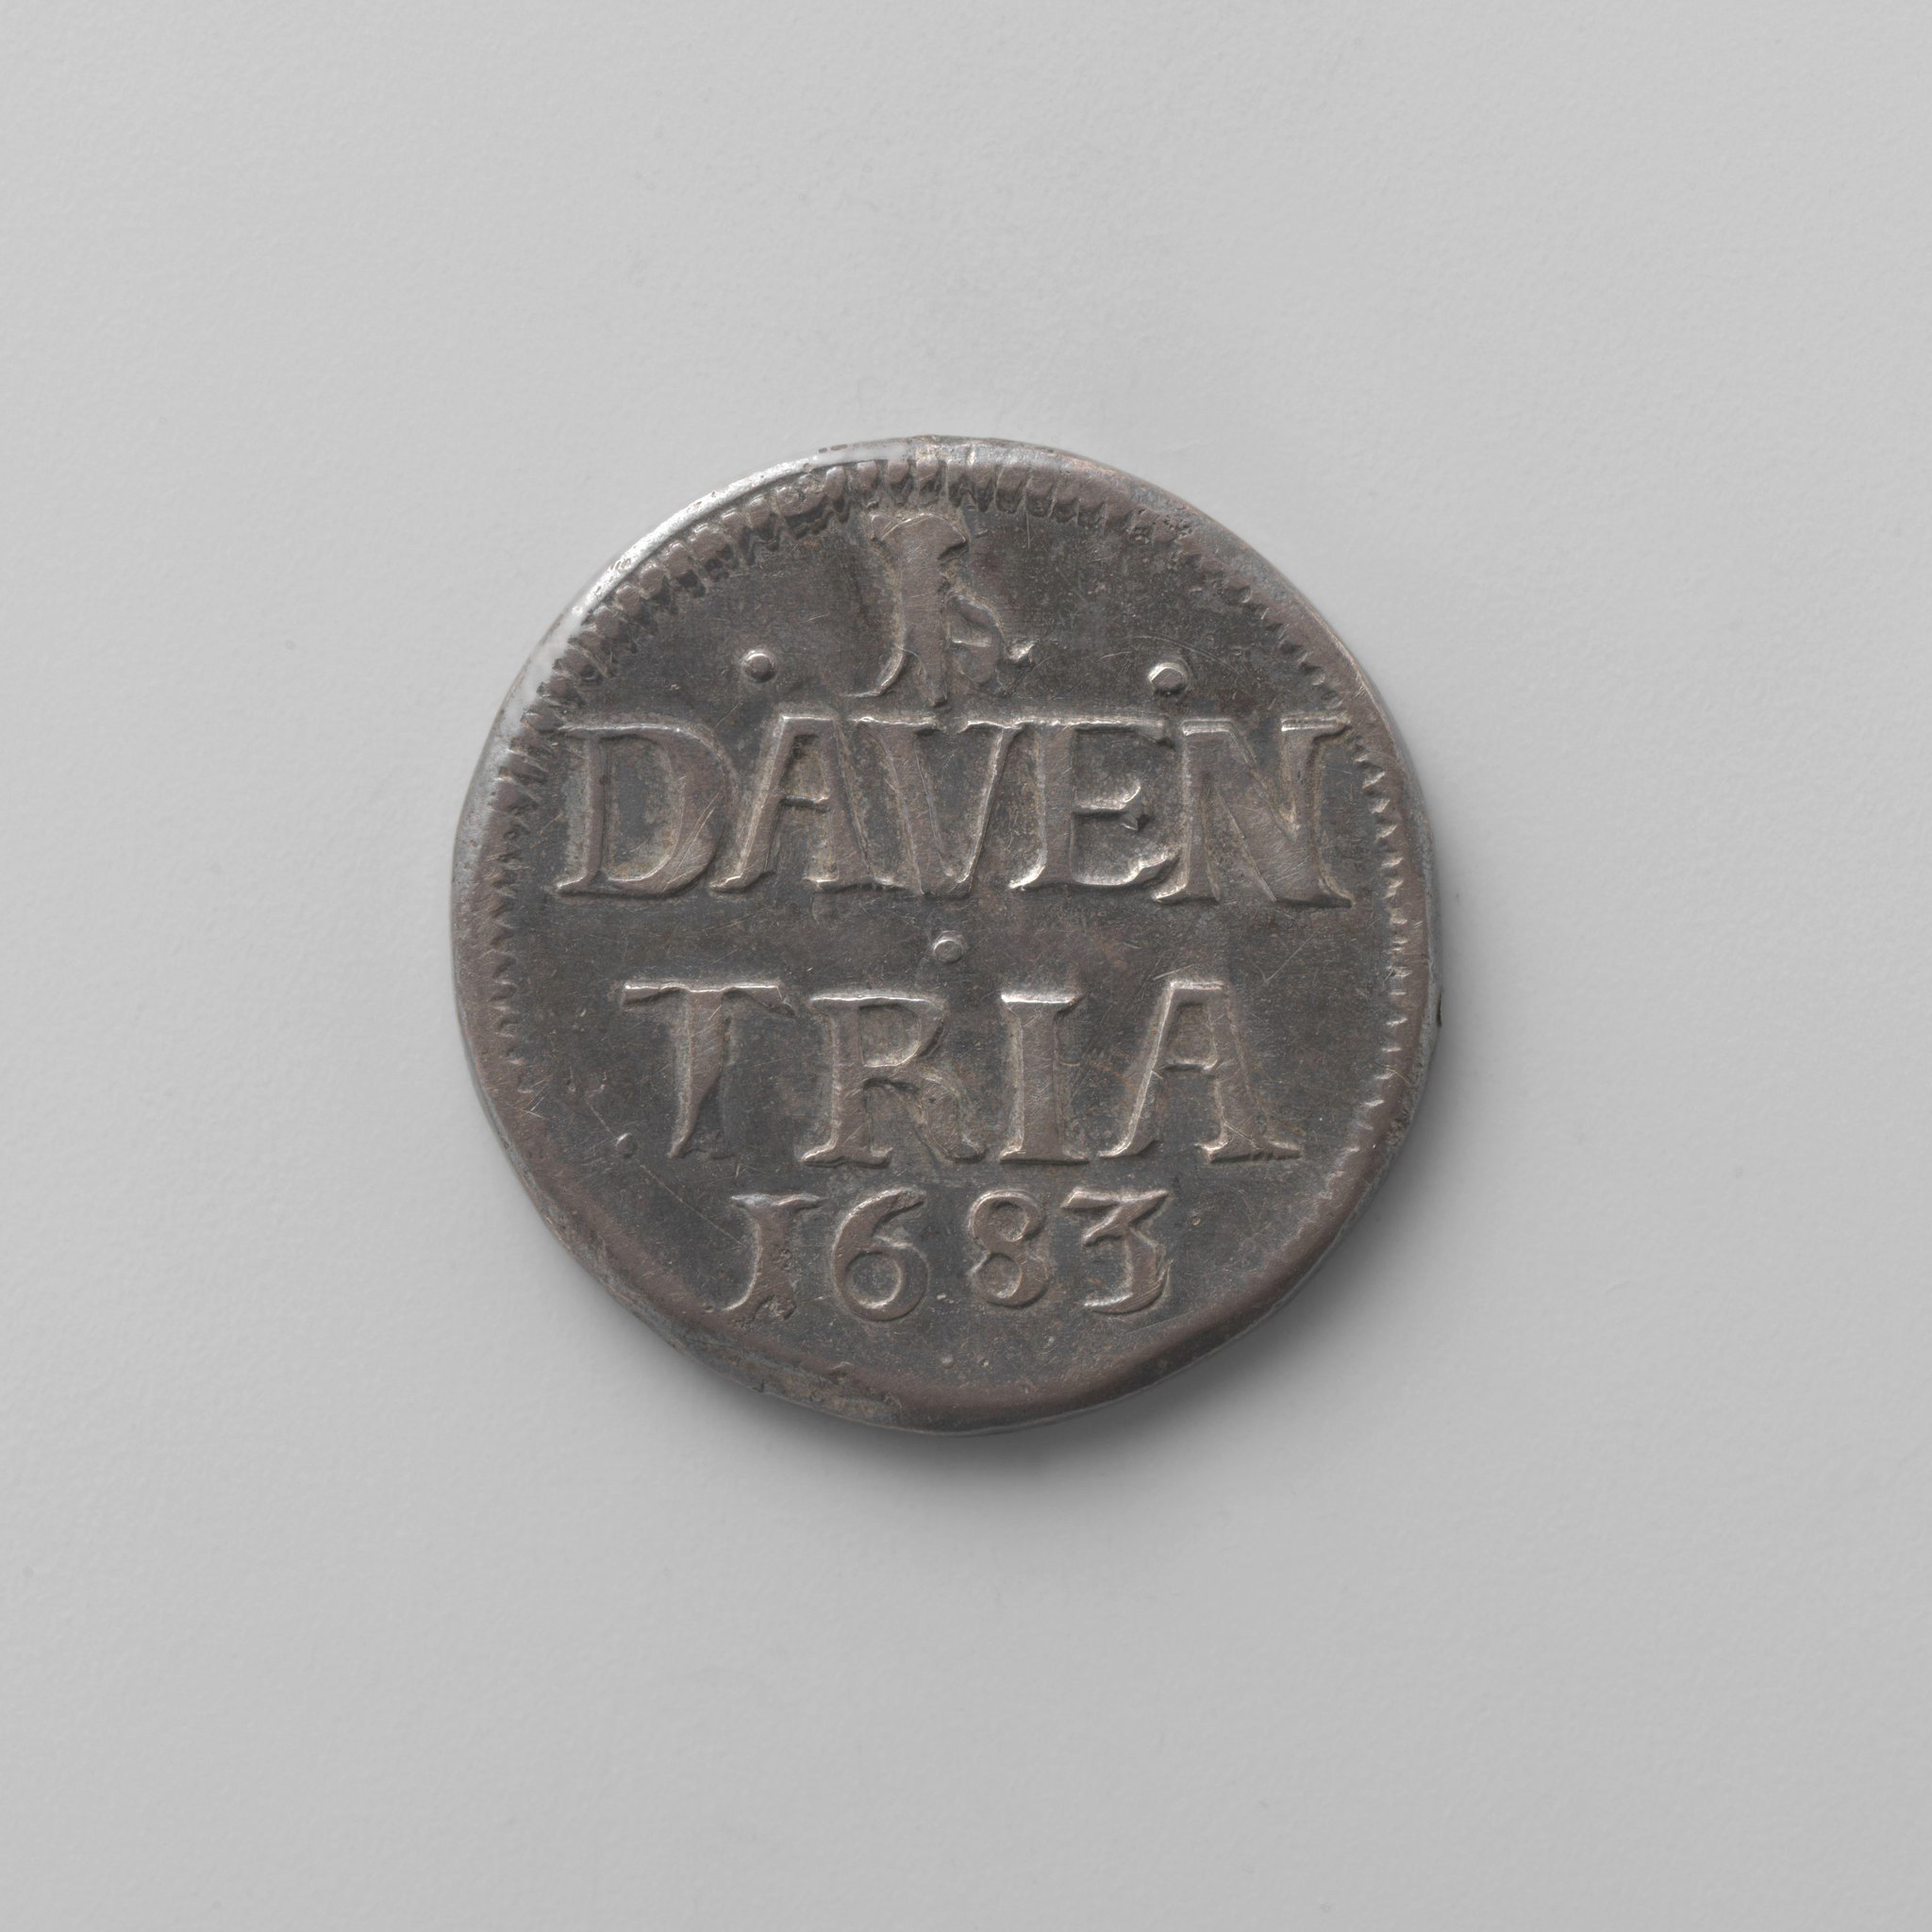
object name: coin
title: Dubbele stuiver van Deventer, 1683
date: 1683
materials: silver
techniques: striking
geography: deventer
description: Zilveren munt. Voorzijde: tussen waarde-aanduiding 2 S generaliteitsleeuw. Keerzijde: tweeregelig opschrift. Daarboven muntmeesterteken en daaronder jaartal. Piedfort.